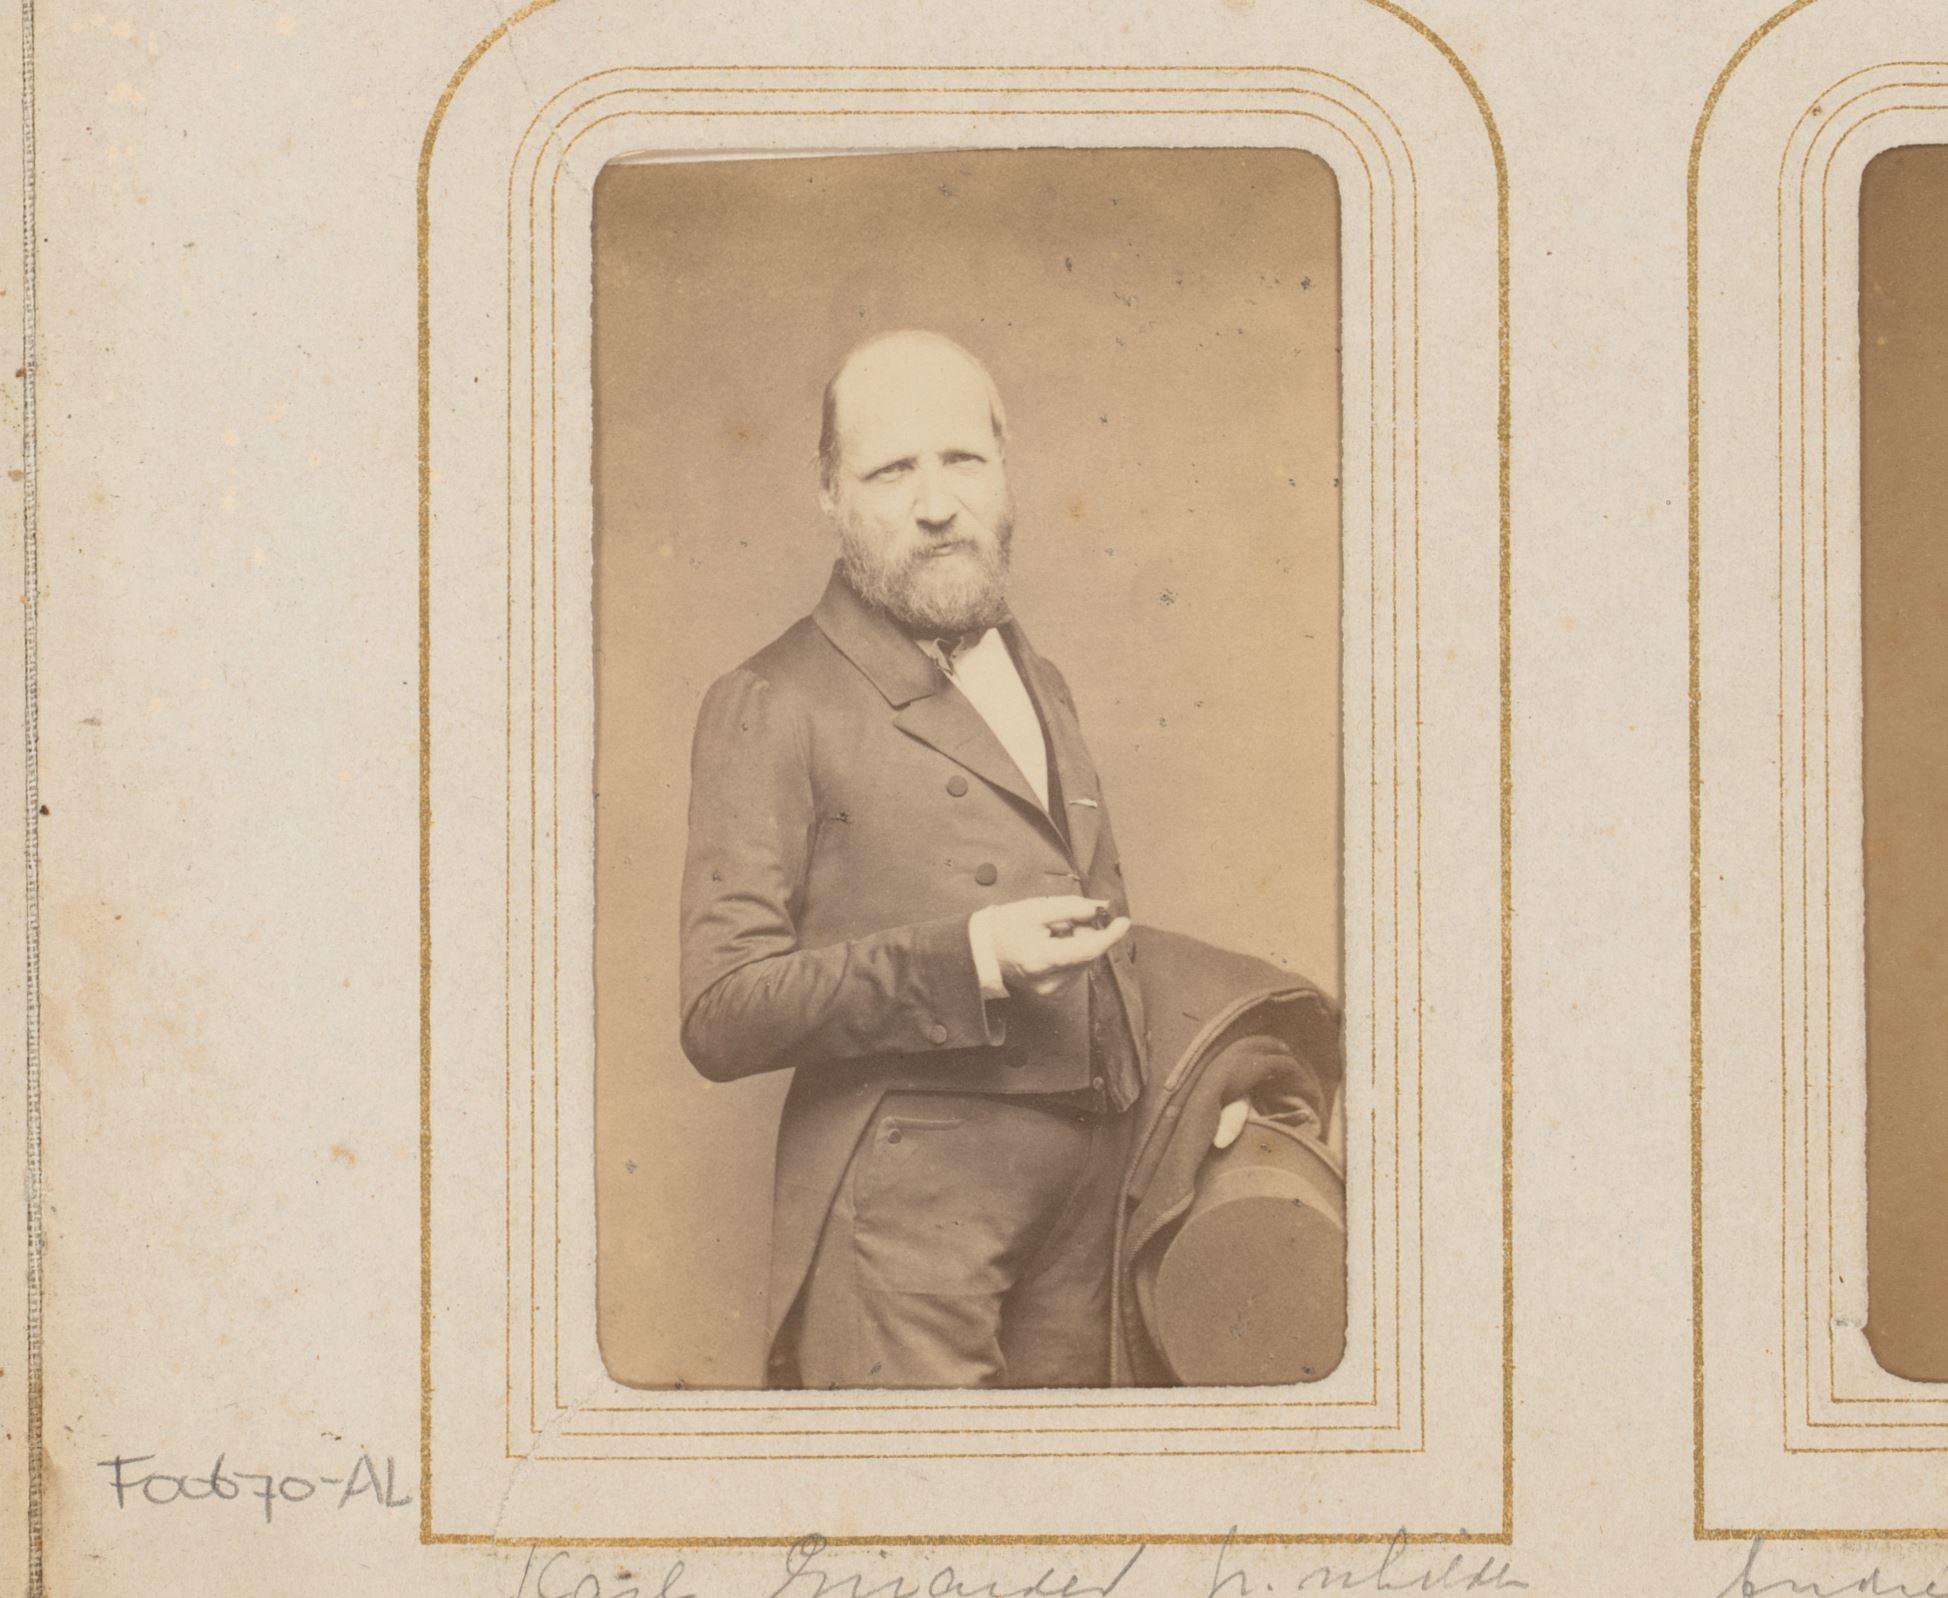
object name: album leaf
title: Portret van Karl Girardet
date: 1867-1871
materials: cardboard, photographic support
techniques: albumen print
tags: paris, karl girardet, historical persons, portrait, self-portrait of painter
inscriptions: inscription: ‘Photographie/ Carjat & Cie/ fondée en 1861/ Legé & Bergeron (...)’, name: ‘Karl Girardet’, annotation: ‘Karl Girardet fr. schilder/ 1813-1871 (Lege & Bergeron)’